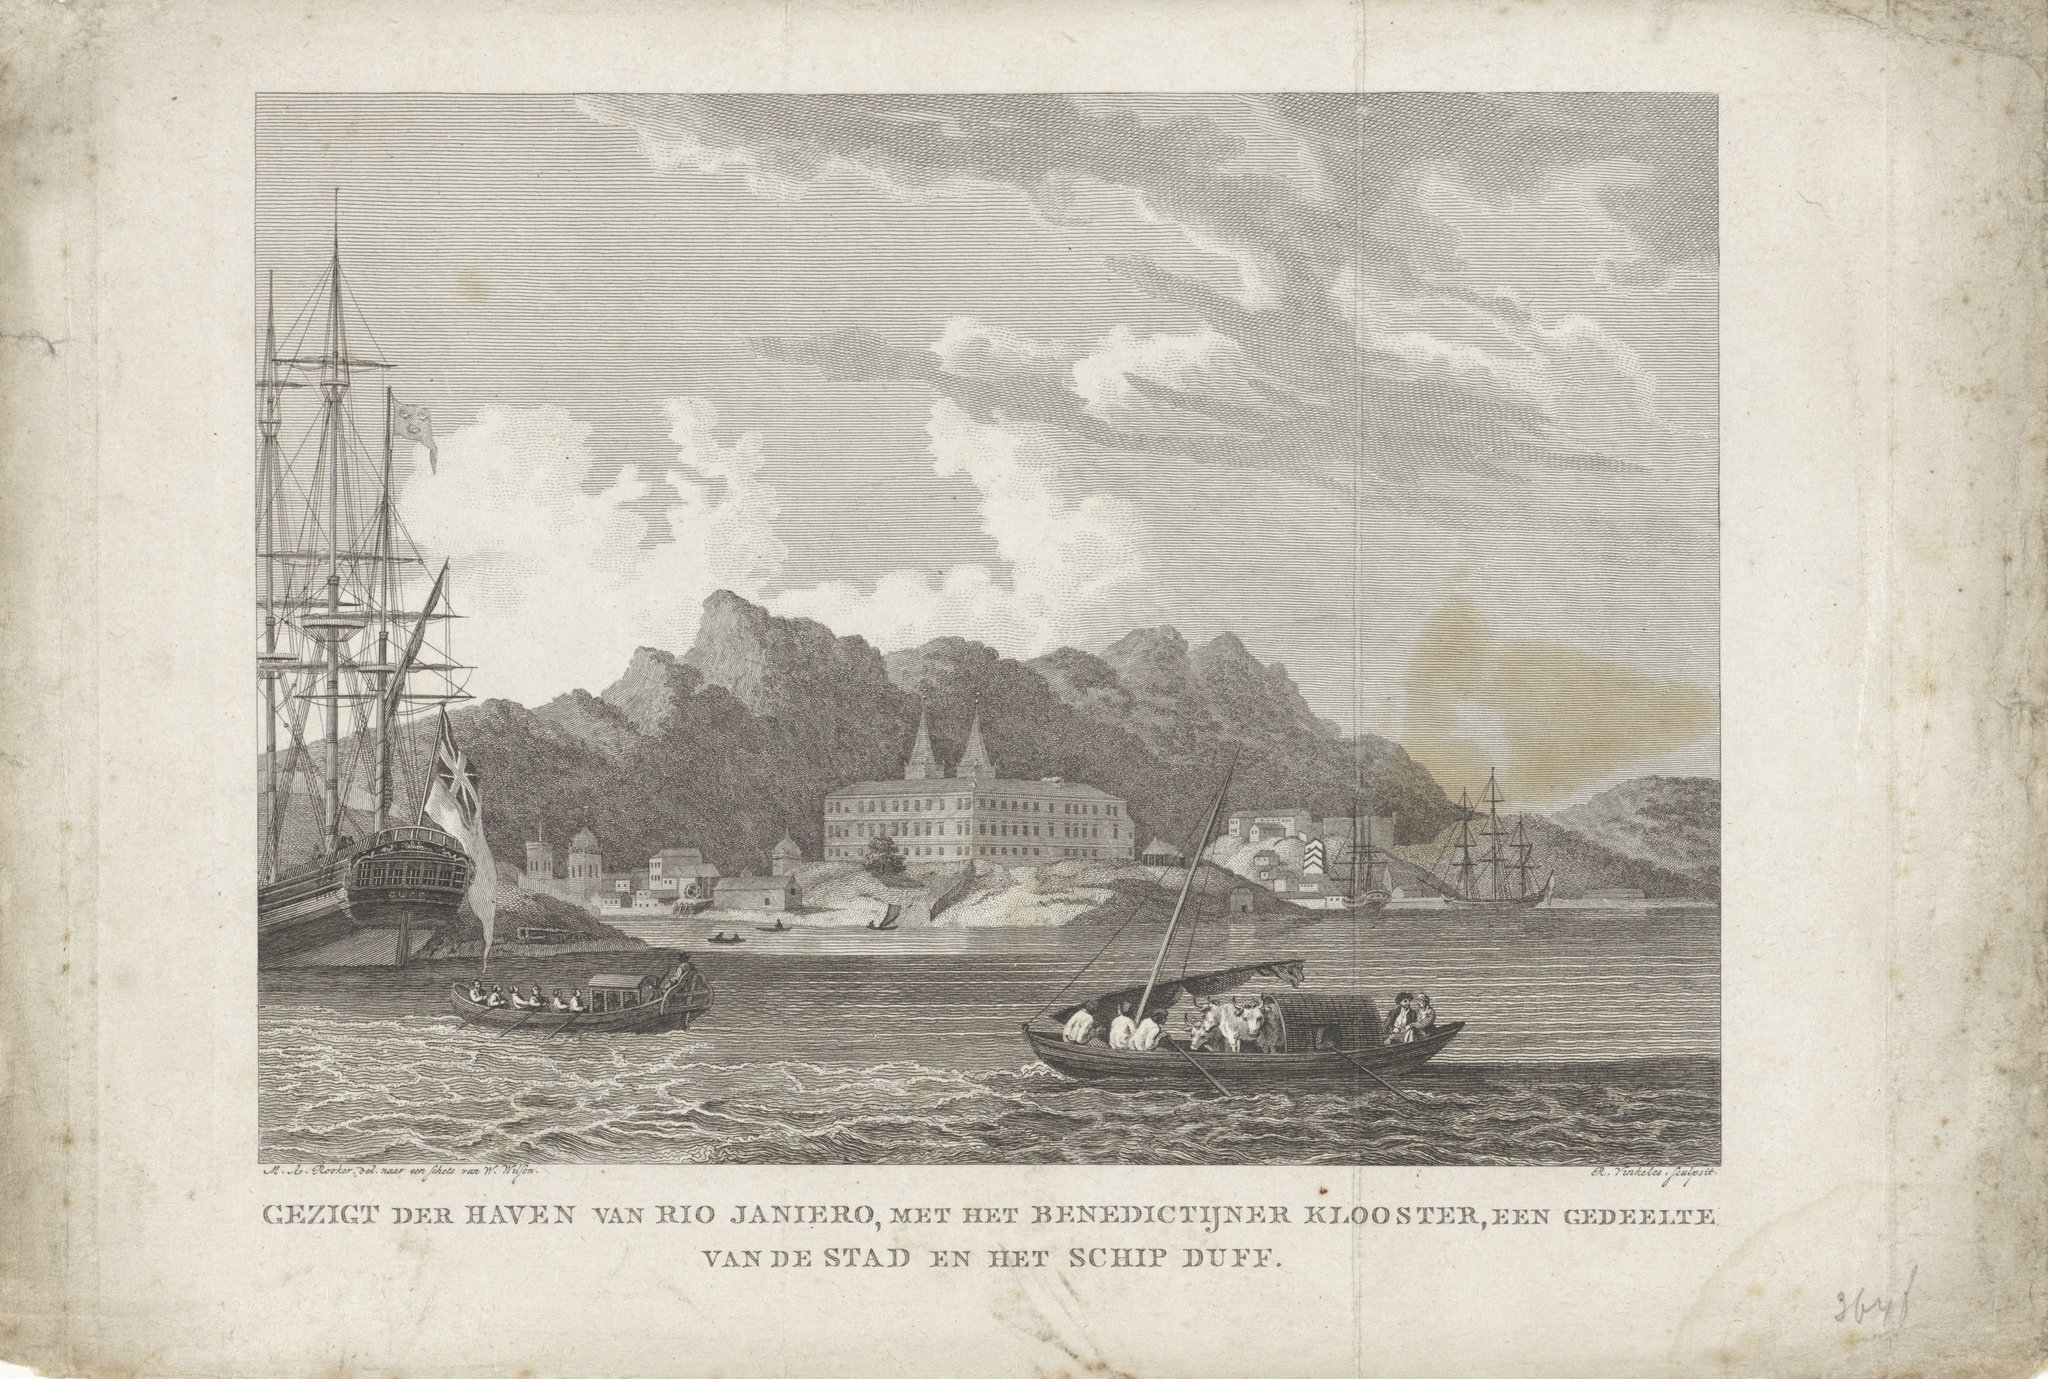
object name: print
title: Gezicht op de haven van Rio de Janeiro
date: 1753-1816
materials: paper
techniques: engraving, etching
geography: amsterdam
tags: harbour, abbey, monastery, convent ~ roman catholic church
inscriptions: collector's mark: Lugt 2228